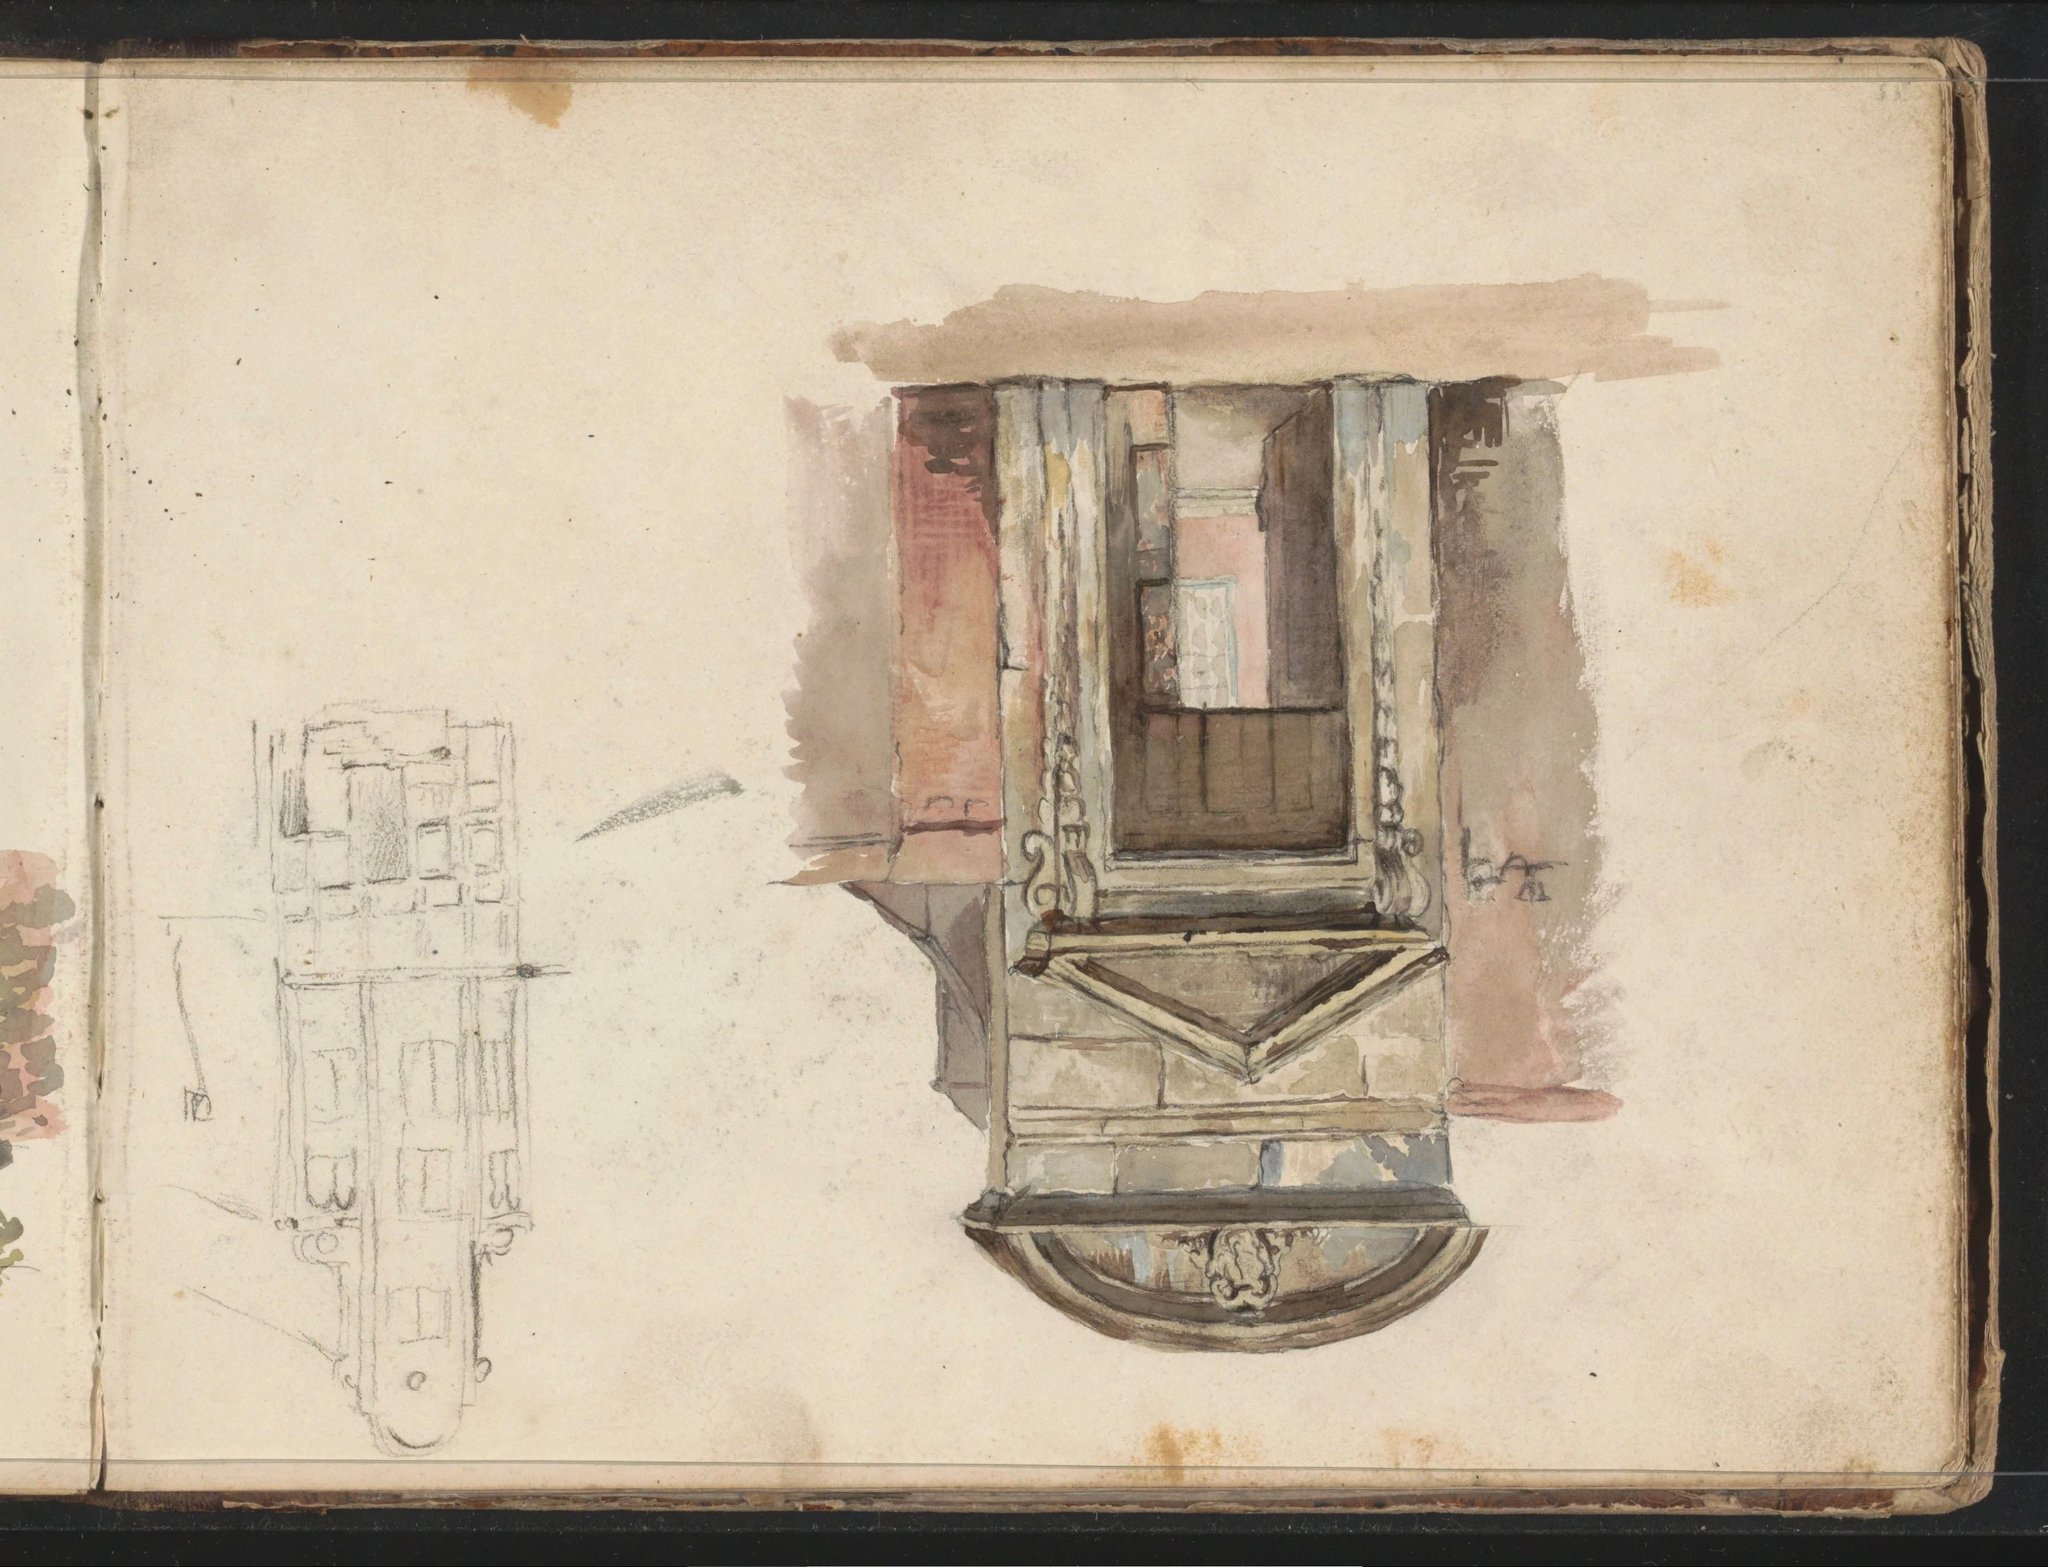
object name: sketchbook leaf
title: Poort naar een binnenplaats en een gevel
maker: willem troost (ii)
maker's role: draughtsman, painter, print maker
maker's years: 1812-1893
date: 1822-1893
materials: chalk, paper, pencil, watercolor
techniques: brush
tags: façade (of house or building)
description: Blad 55 recto uit een schetsboek met 36 bladen.